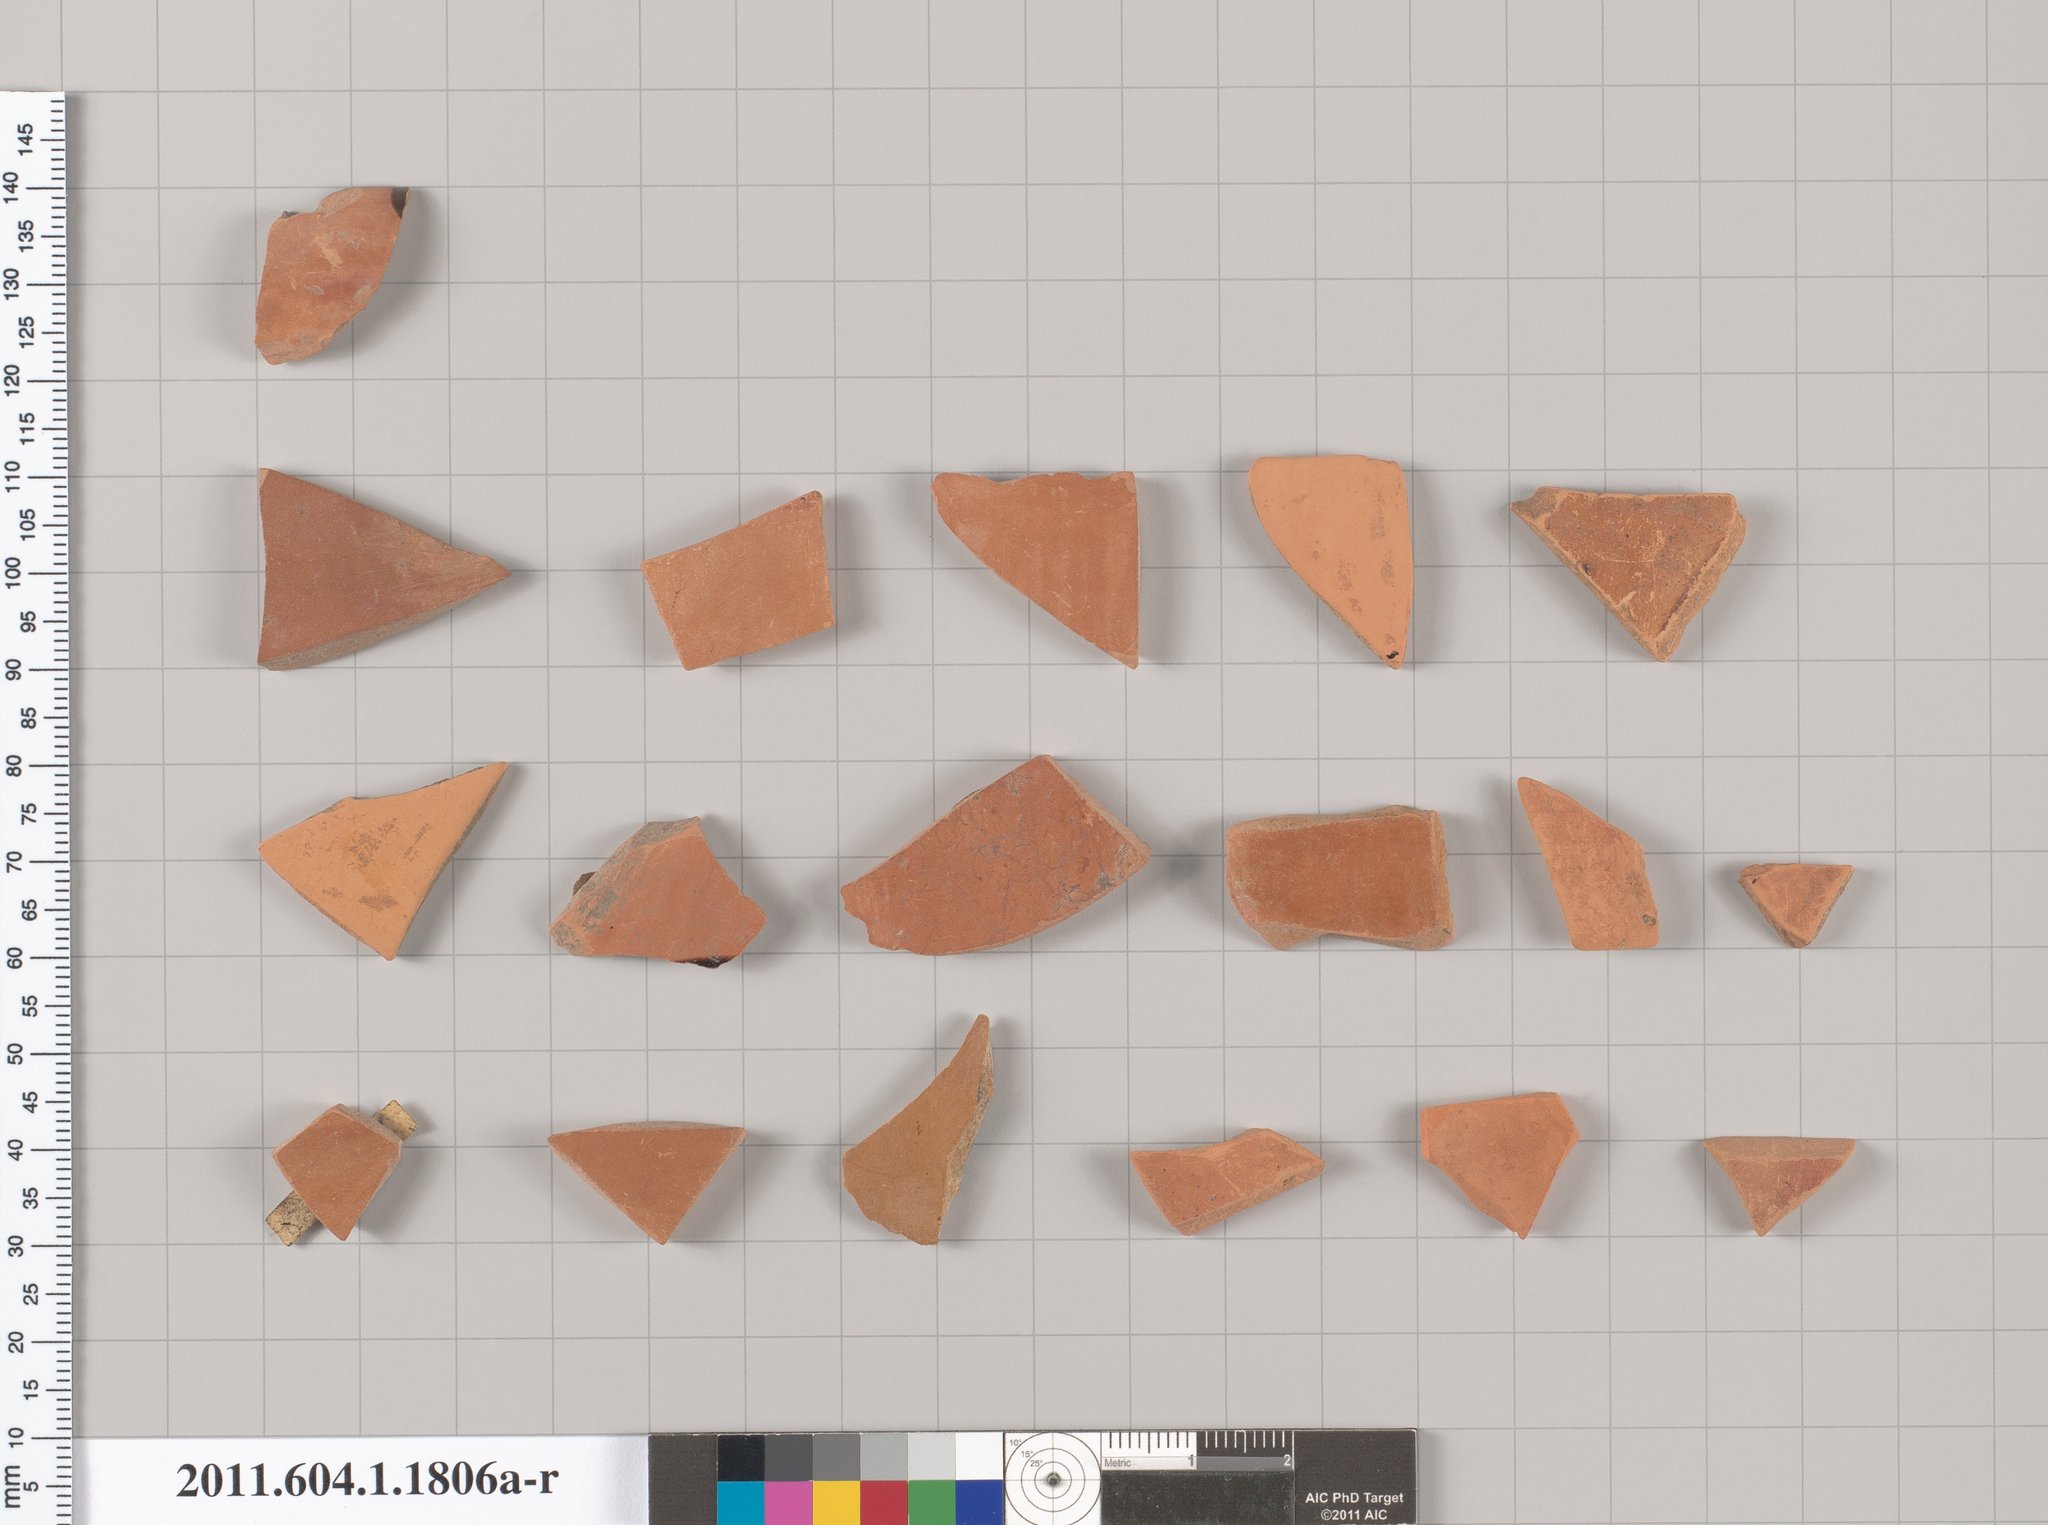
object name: kylix fragment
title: Terracotta rim fragments of kylikes(drinking cups)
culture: greek, attic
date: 500-401 BCE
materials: terracotta